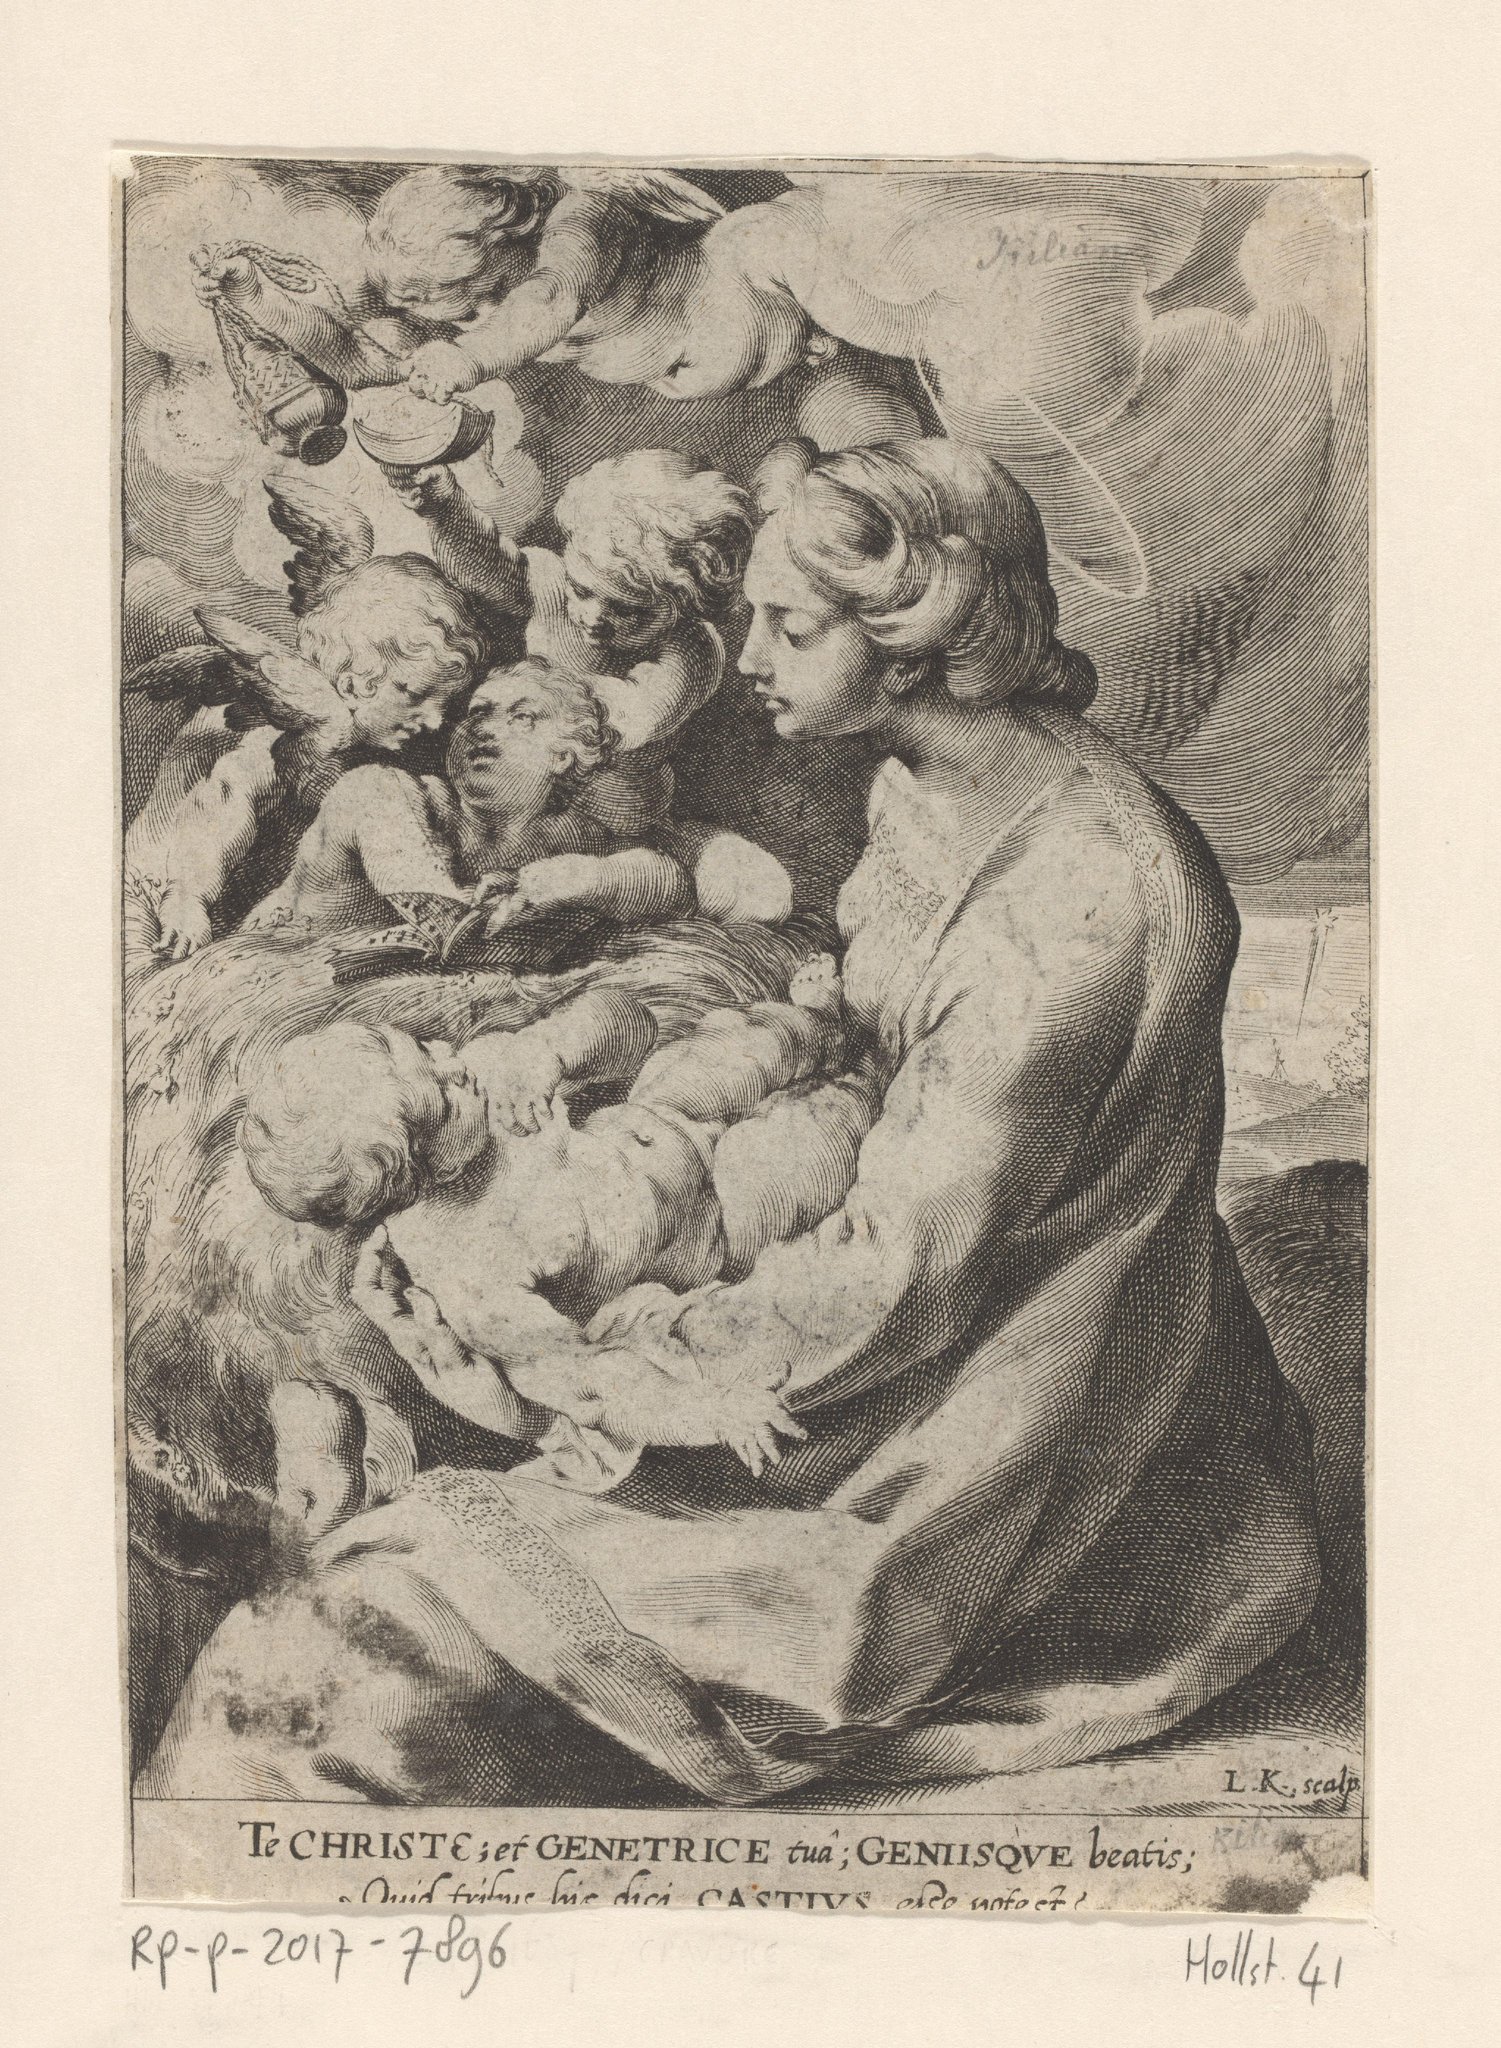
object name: print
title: Maria met kind en engelen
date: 1589-1639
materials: paper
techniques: engraving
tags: mary sitting on the ground, the christ-child in front of her, lying in her lap (+ angels floating in the air)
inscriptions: collector's mark: Lugt 2228